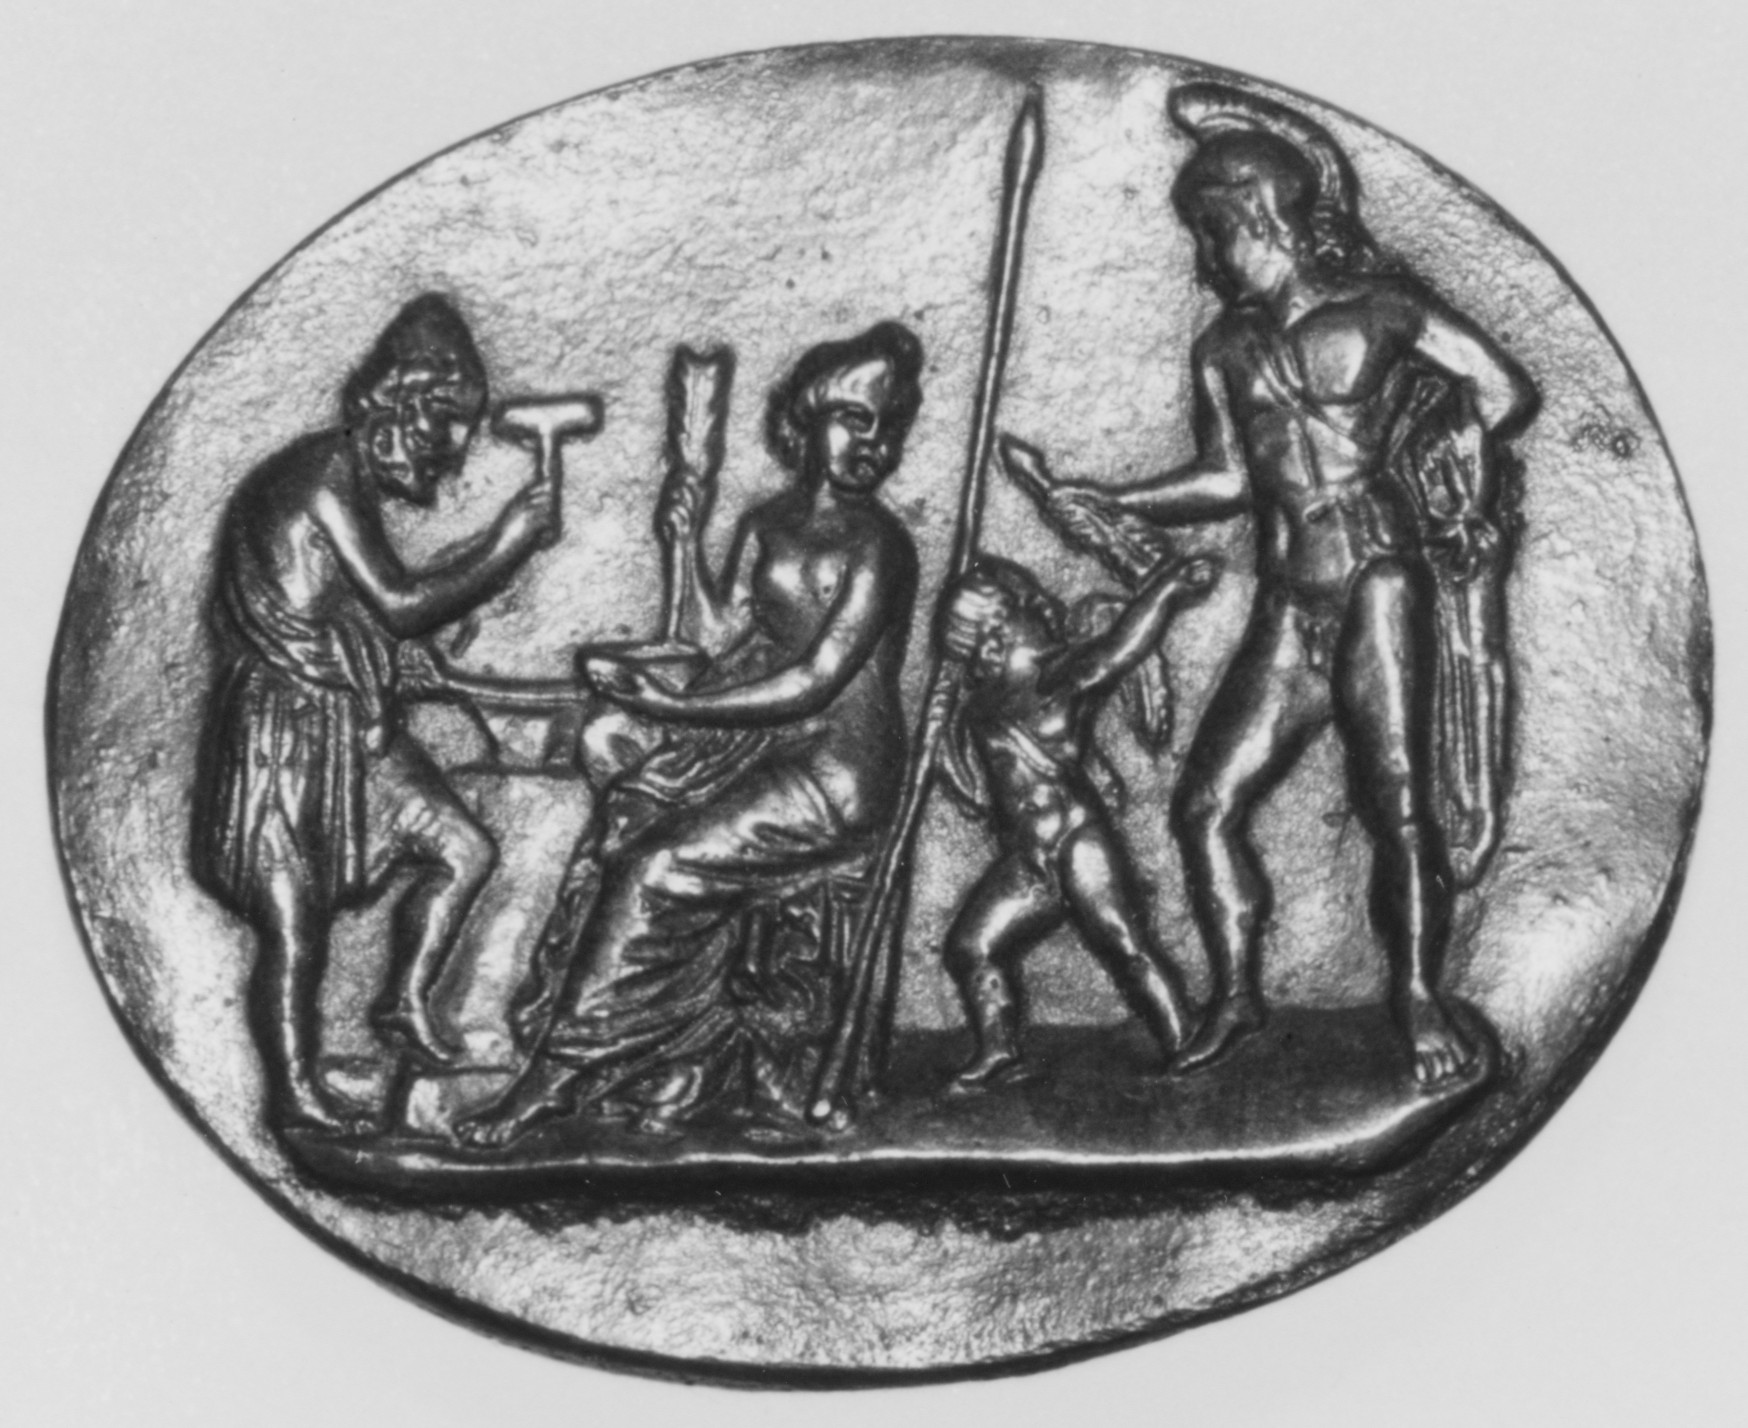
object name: plaquette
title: Mars, Venus and Cupid at Vulcan's forge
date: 1701-1800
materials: bronze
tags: cupid,mars,venus,vulcan